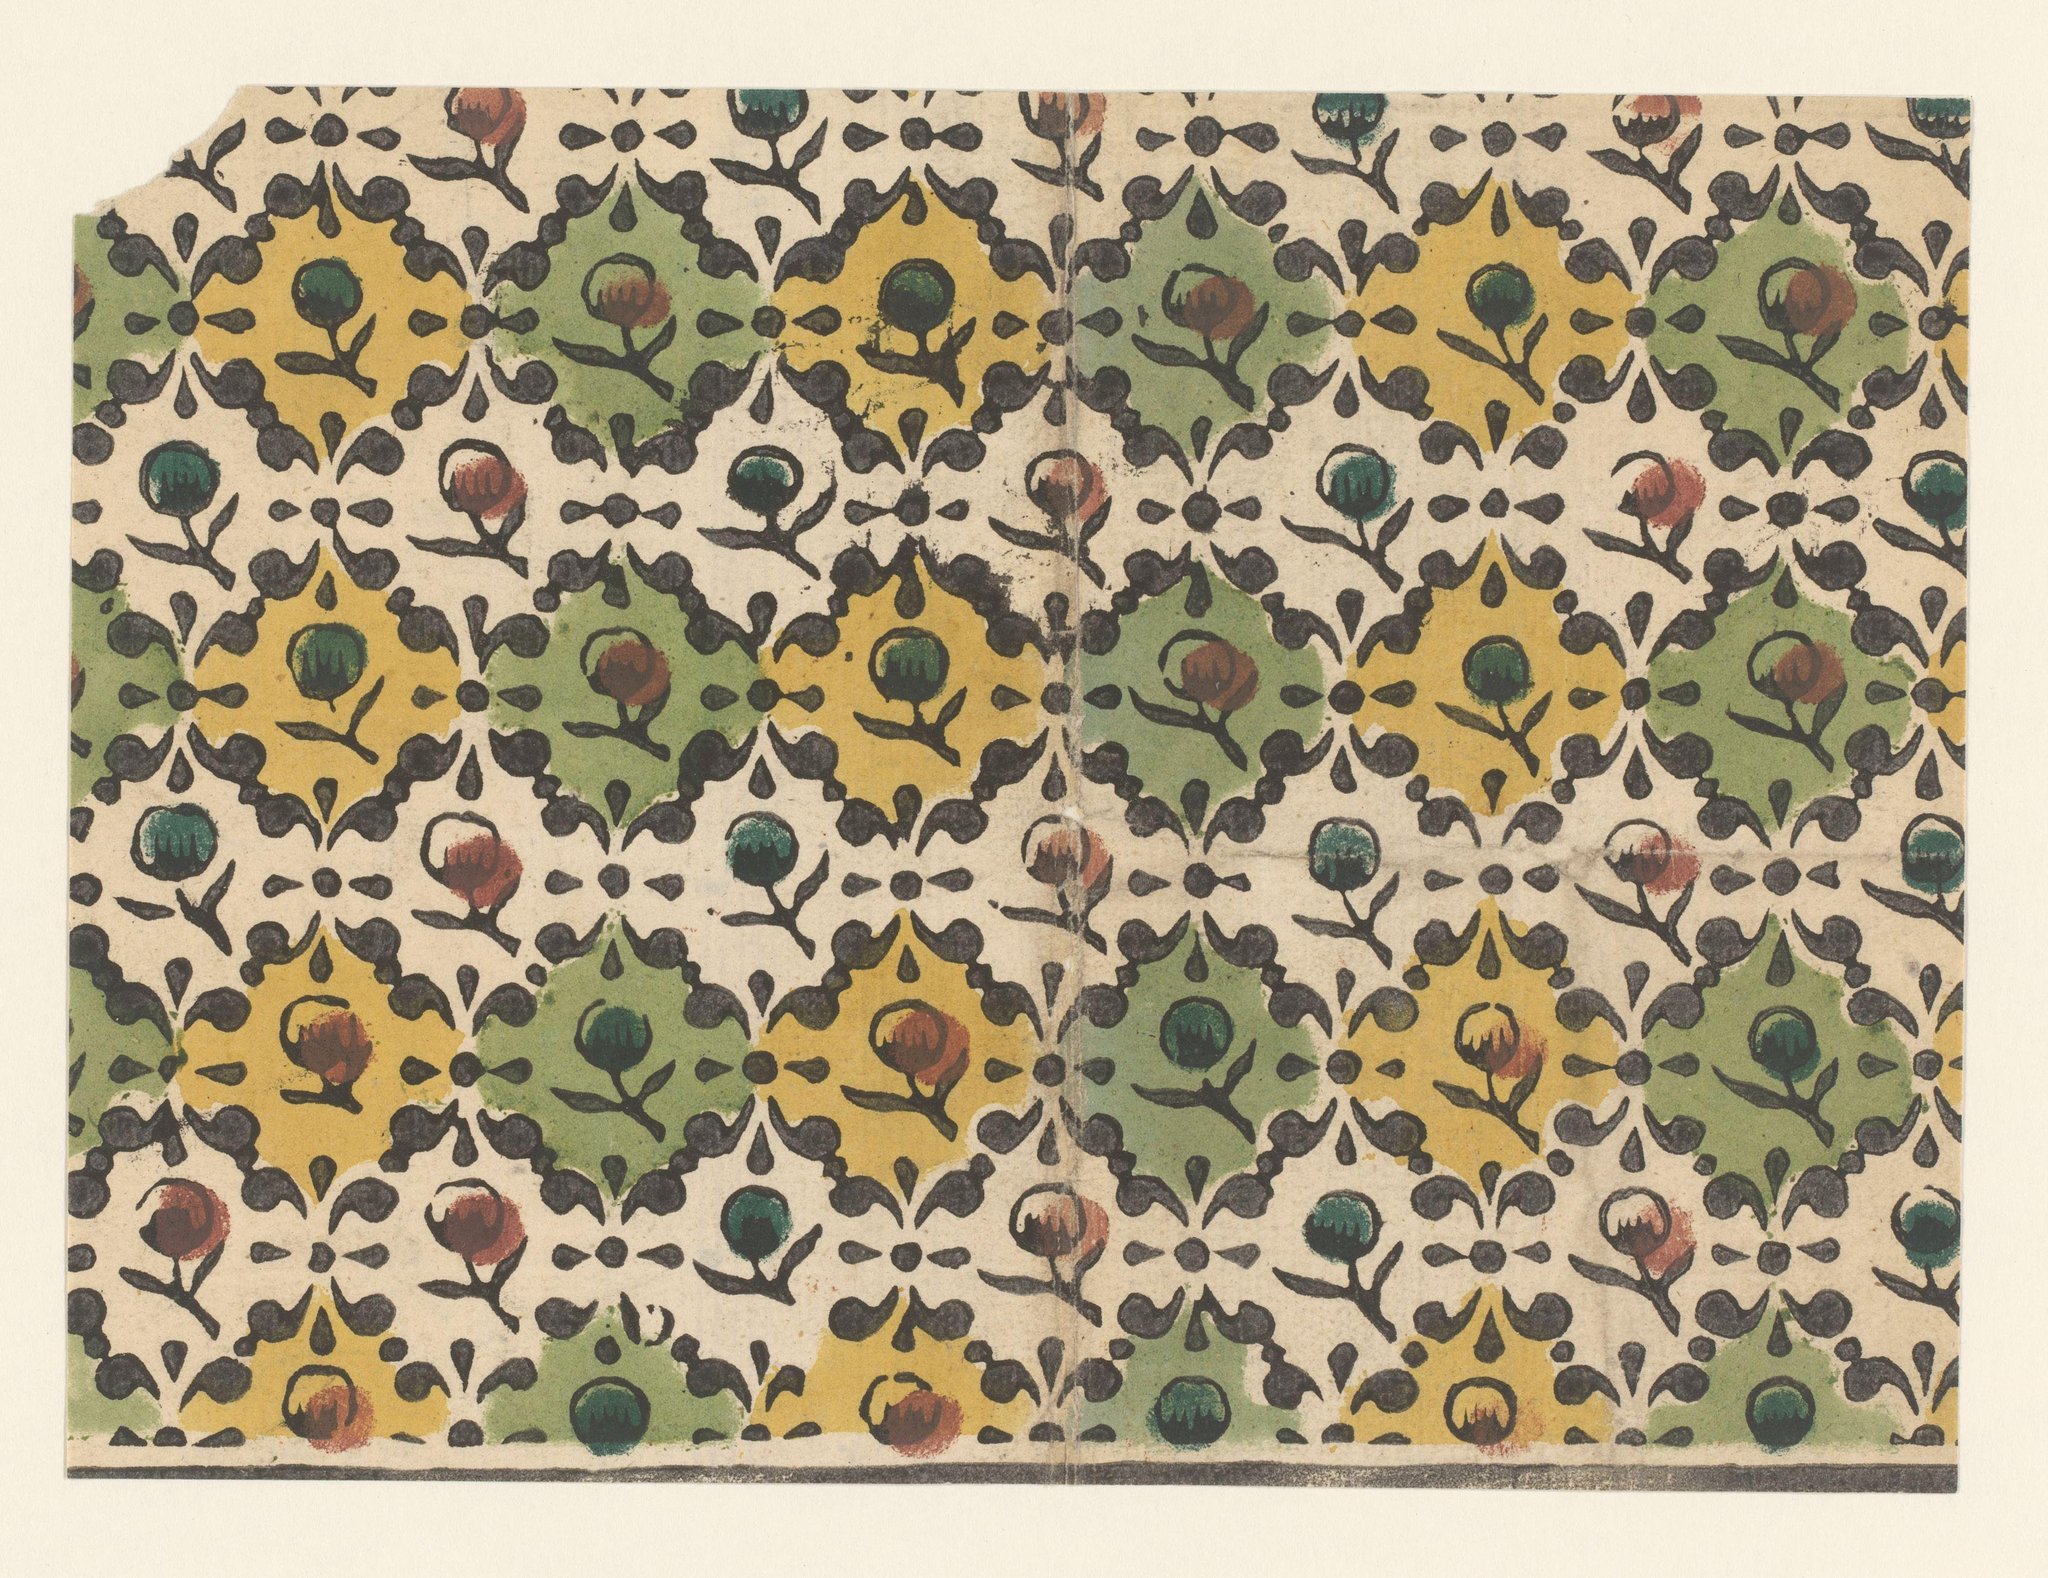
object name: wrapper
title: Blad met strooipatroon van bloem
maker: Anonymous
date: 1700-1850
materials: paper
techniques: printing block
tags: ornament derived from plant forms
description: Blad met strooipatroon van een bloem in een soort cartouche van bladelementen. Gebruikt als omslag, het middendeel gedoubleerd.